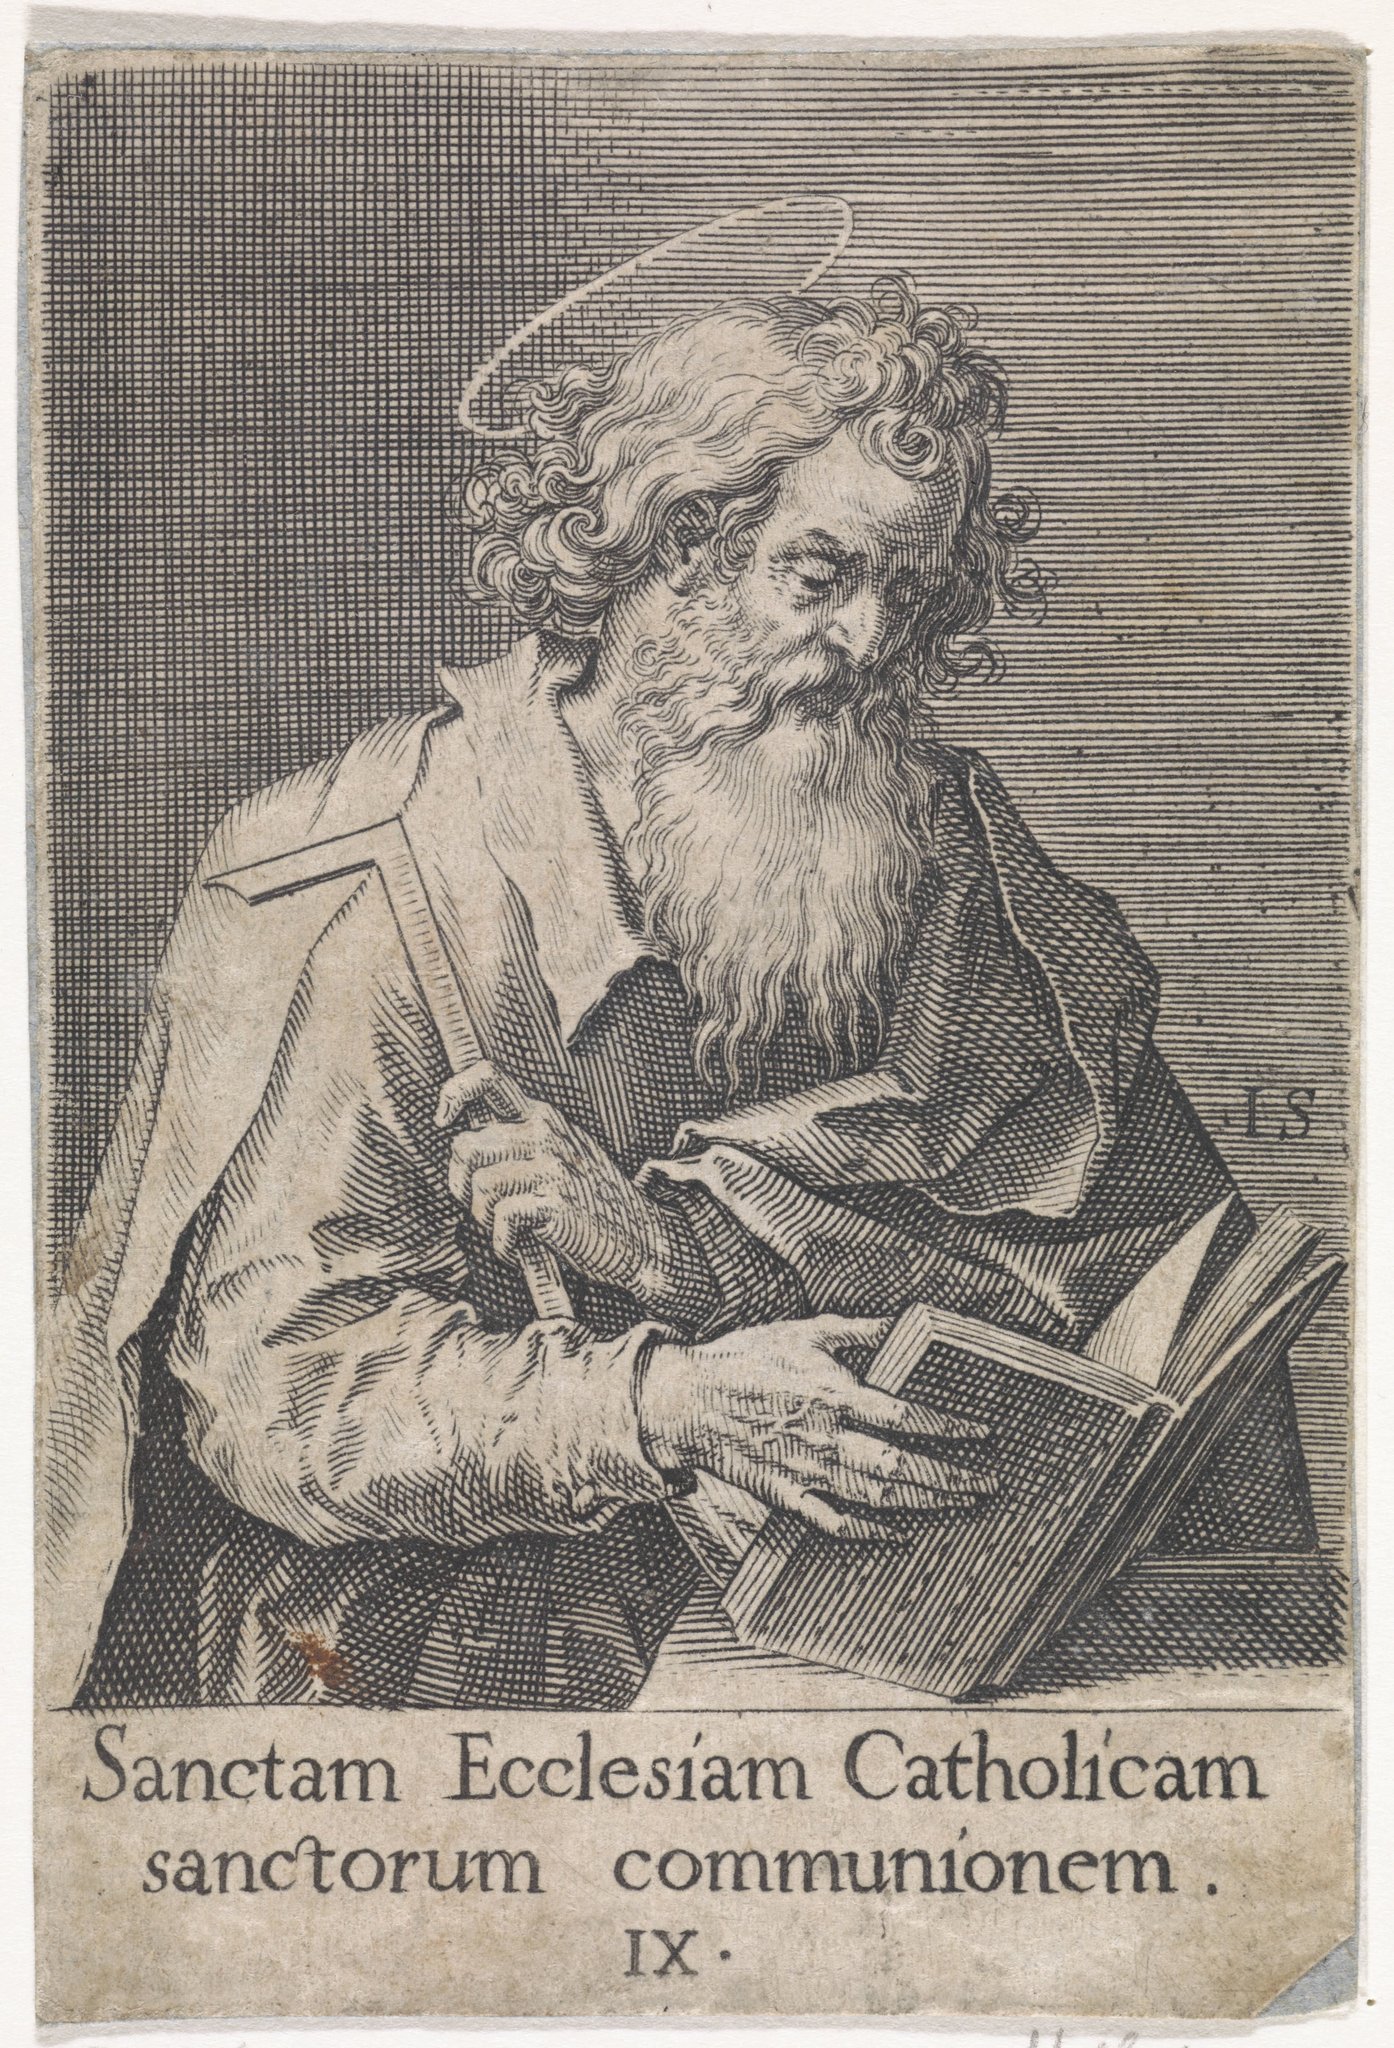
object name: print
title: Apostel Matteüs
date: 1570-1600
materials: paper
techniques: engraving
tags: the apostle and evangelist matthew (mattheus); possible attributes: angel, axe, book, halberd, pen and inkhorn, purse, scroll, square, sword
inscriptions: collector's mark: Lugt 240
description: De apostel Matteüs, met als attribuut de tekendriehoek. De prent heeft een Latijns onderschrijft met een regel uit het Credo. De elfde prent in een serie van veertien waarvan de prenten met een apostel genummerd zijn van 1 tot 12.